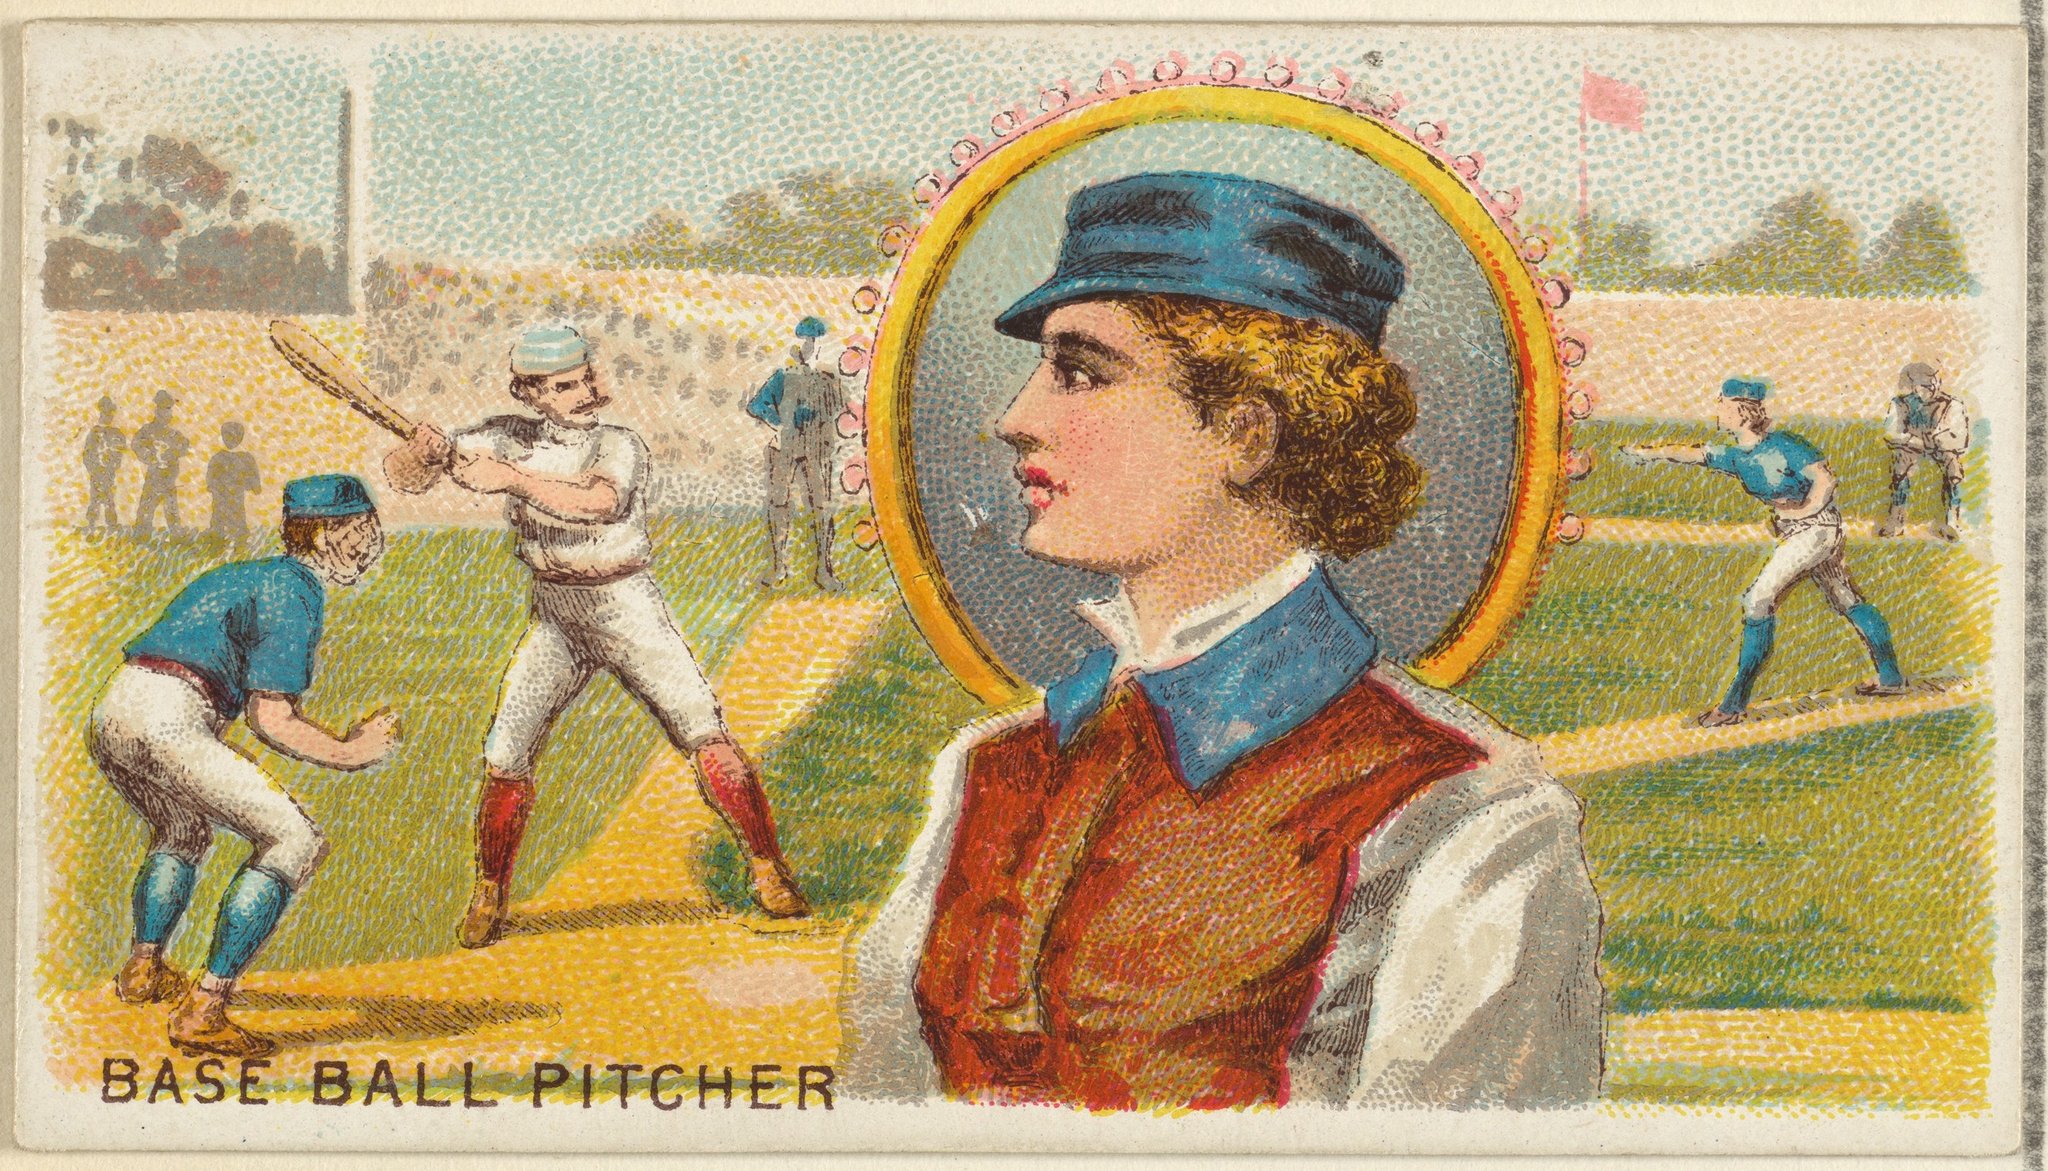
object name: baseball card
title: Baseball Pitcher, from the Games and Sports series (N165) for Old Judge Cigarettes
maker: goodwin & company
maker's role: publisher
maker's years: 1850-1950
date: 1889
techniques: color lithograph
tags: men,women,baseball